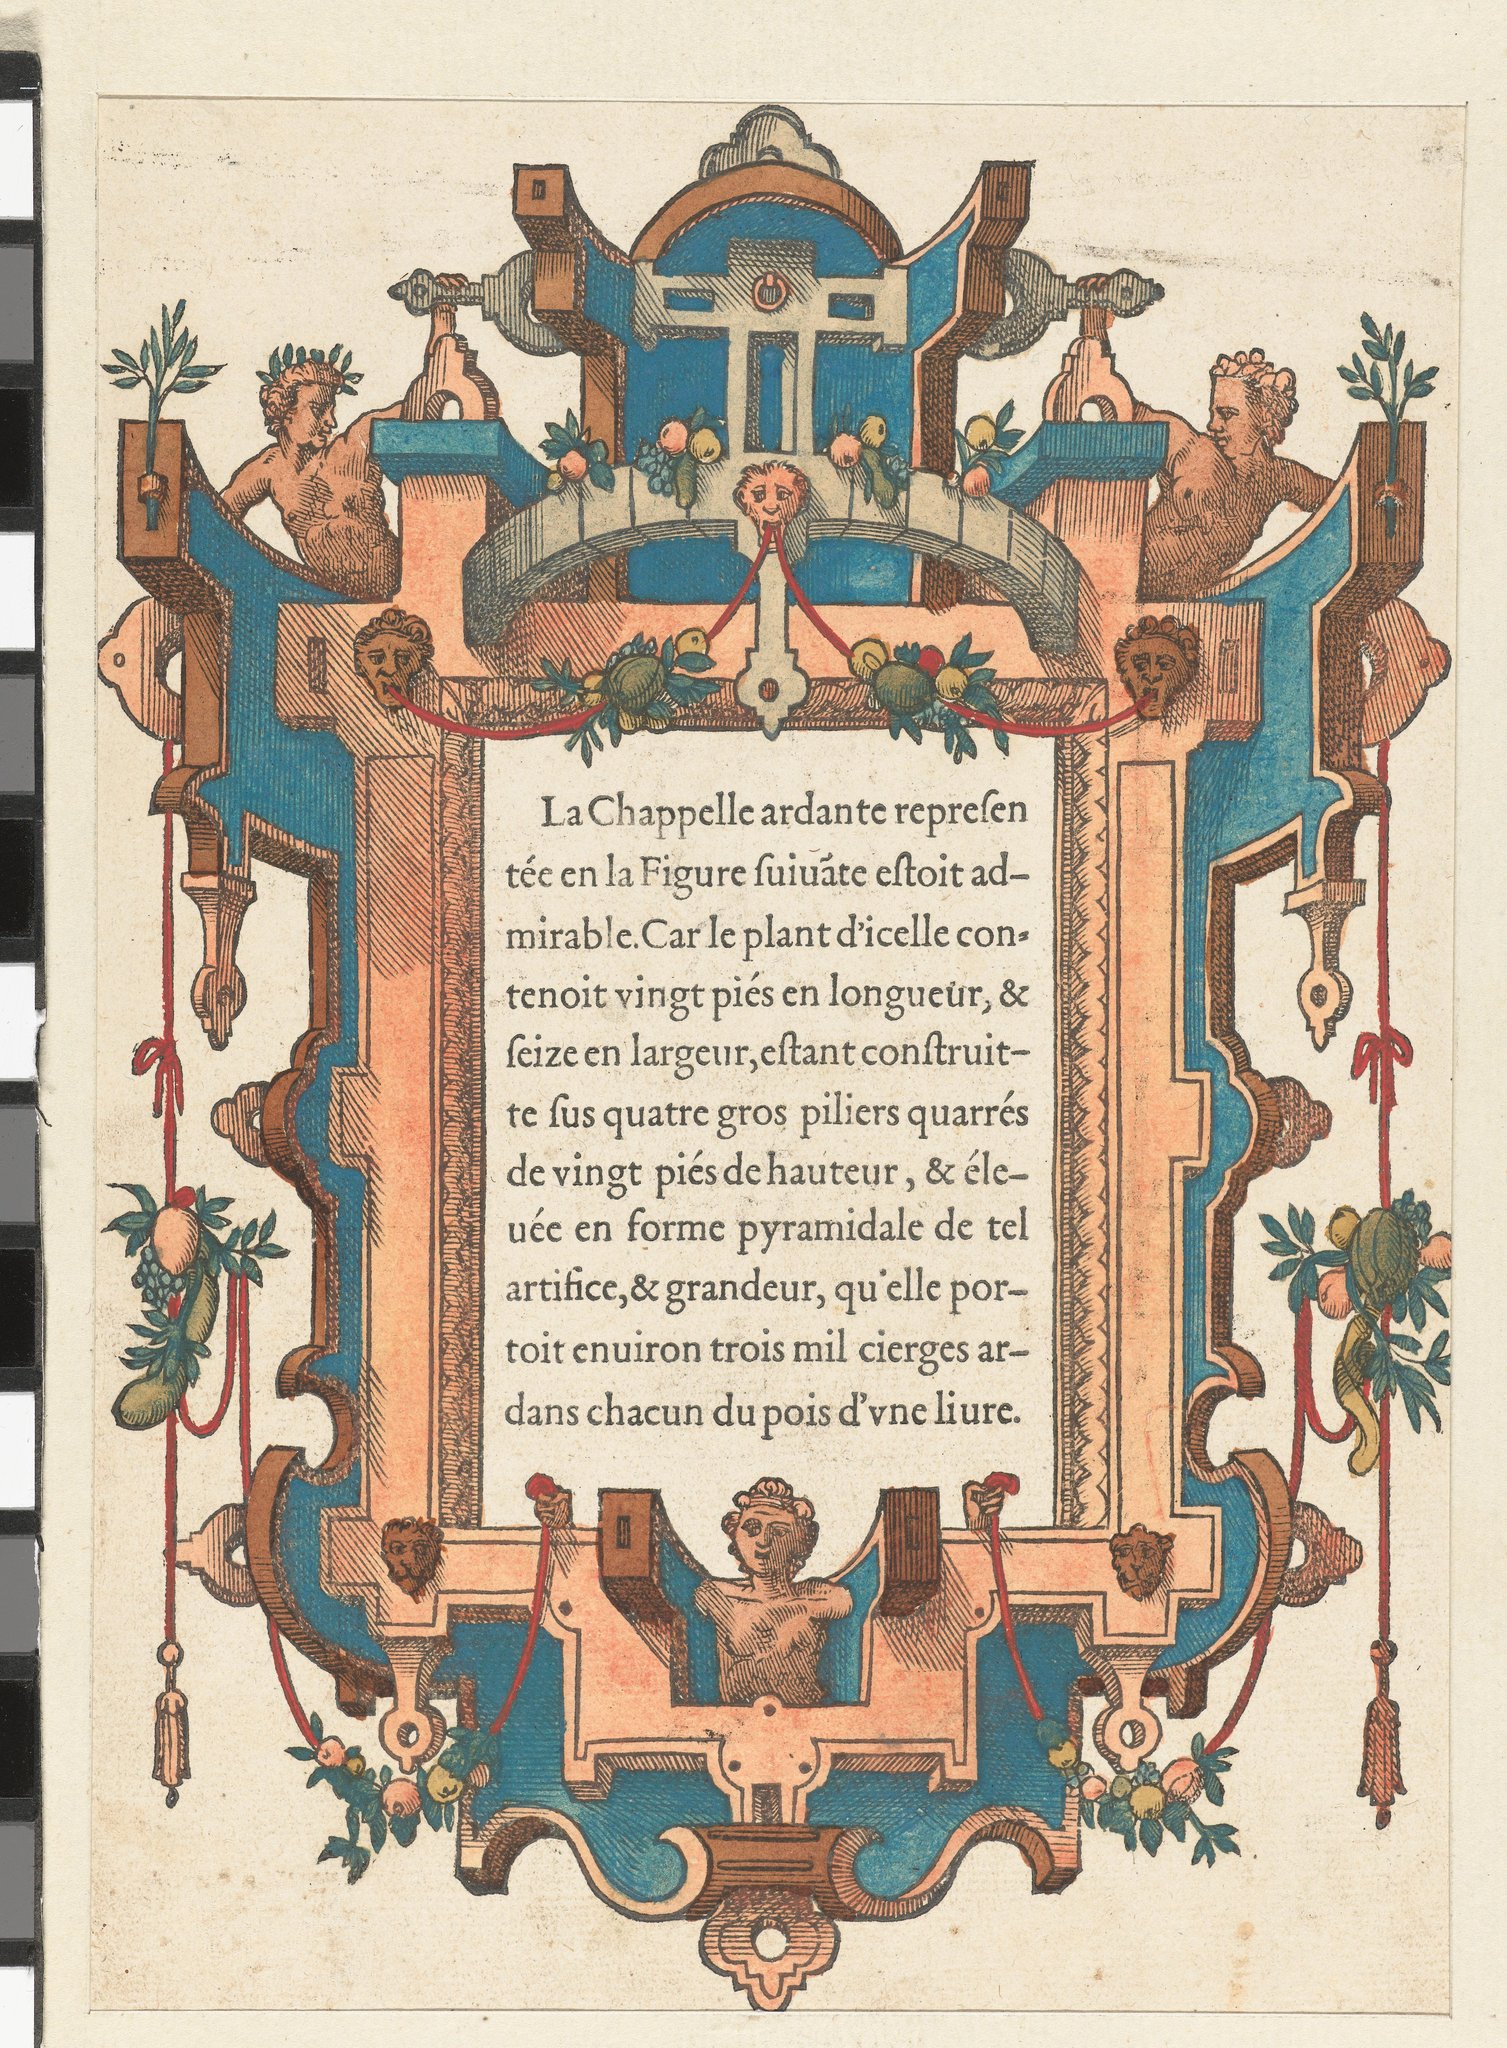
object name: print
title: La magnifique, et sumptueuse Pompe Funebre, faite aus Obseques & Funerailles du tres-grand & tres-victorieus Empereur Charles Cinquième, Celebrées en la Vile de Bruxelles le XXIX. Iour du Mois de Decembre M.D.LVIII. par Philippes Roy Catholique d'Espaignes son Fils.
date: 1559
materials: paper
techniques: hand coloring, letterpress printing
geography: southern netherlands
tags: ghent, charles v (holy roman emperor and king of spain), brussels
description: Tekstblad met beschrijving van de Katafalk met kaarsen, de Chapelle ardente, te monteren voor plaat 1: La Chapelle ardante representée en la Figure suivante (...). Gedrukte tekst binnen ingekleurde ornamentele omlijsting in houtsnede. Onderdeel van de prentreeks van de Begrafenisoptocht van keizer Karel V op 29 december 1558 te Brussel.